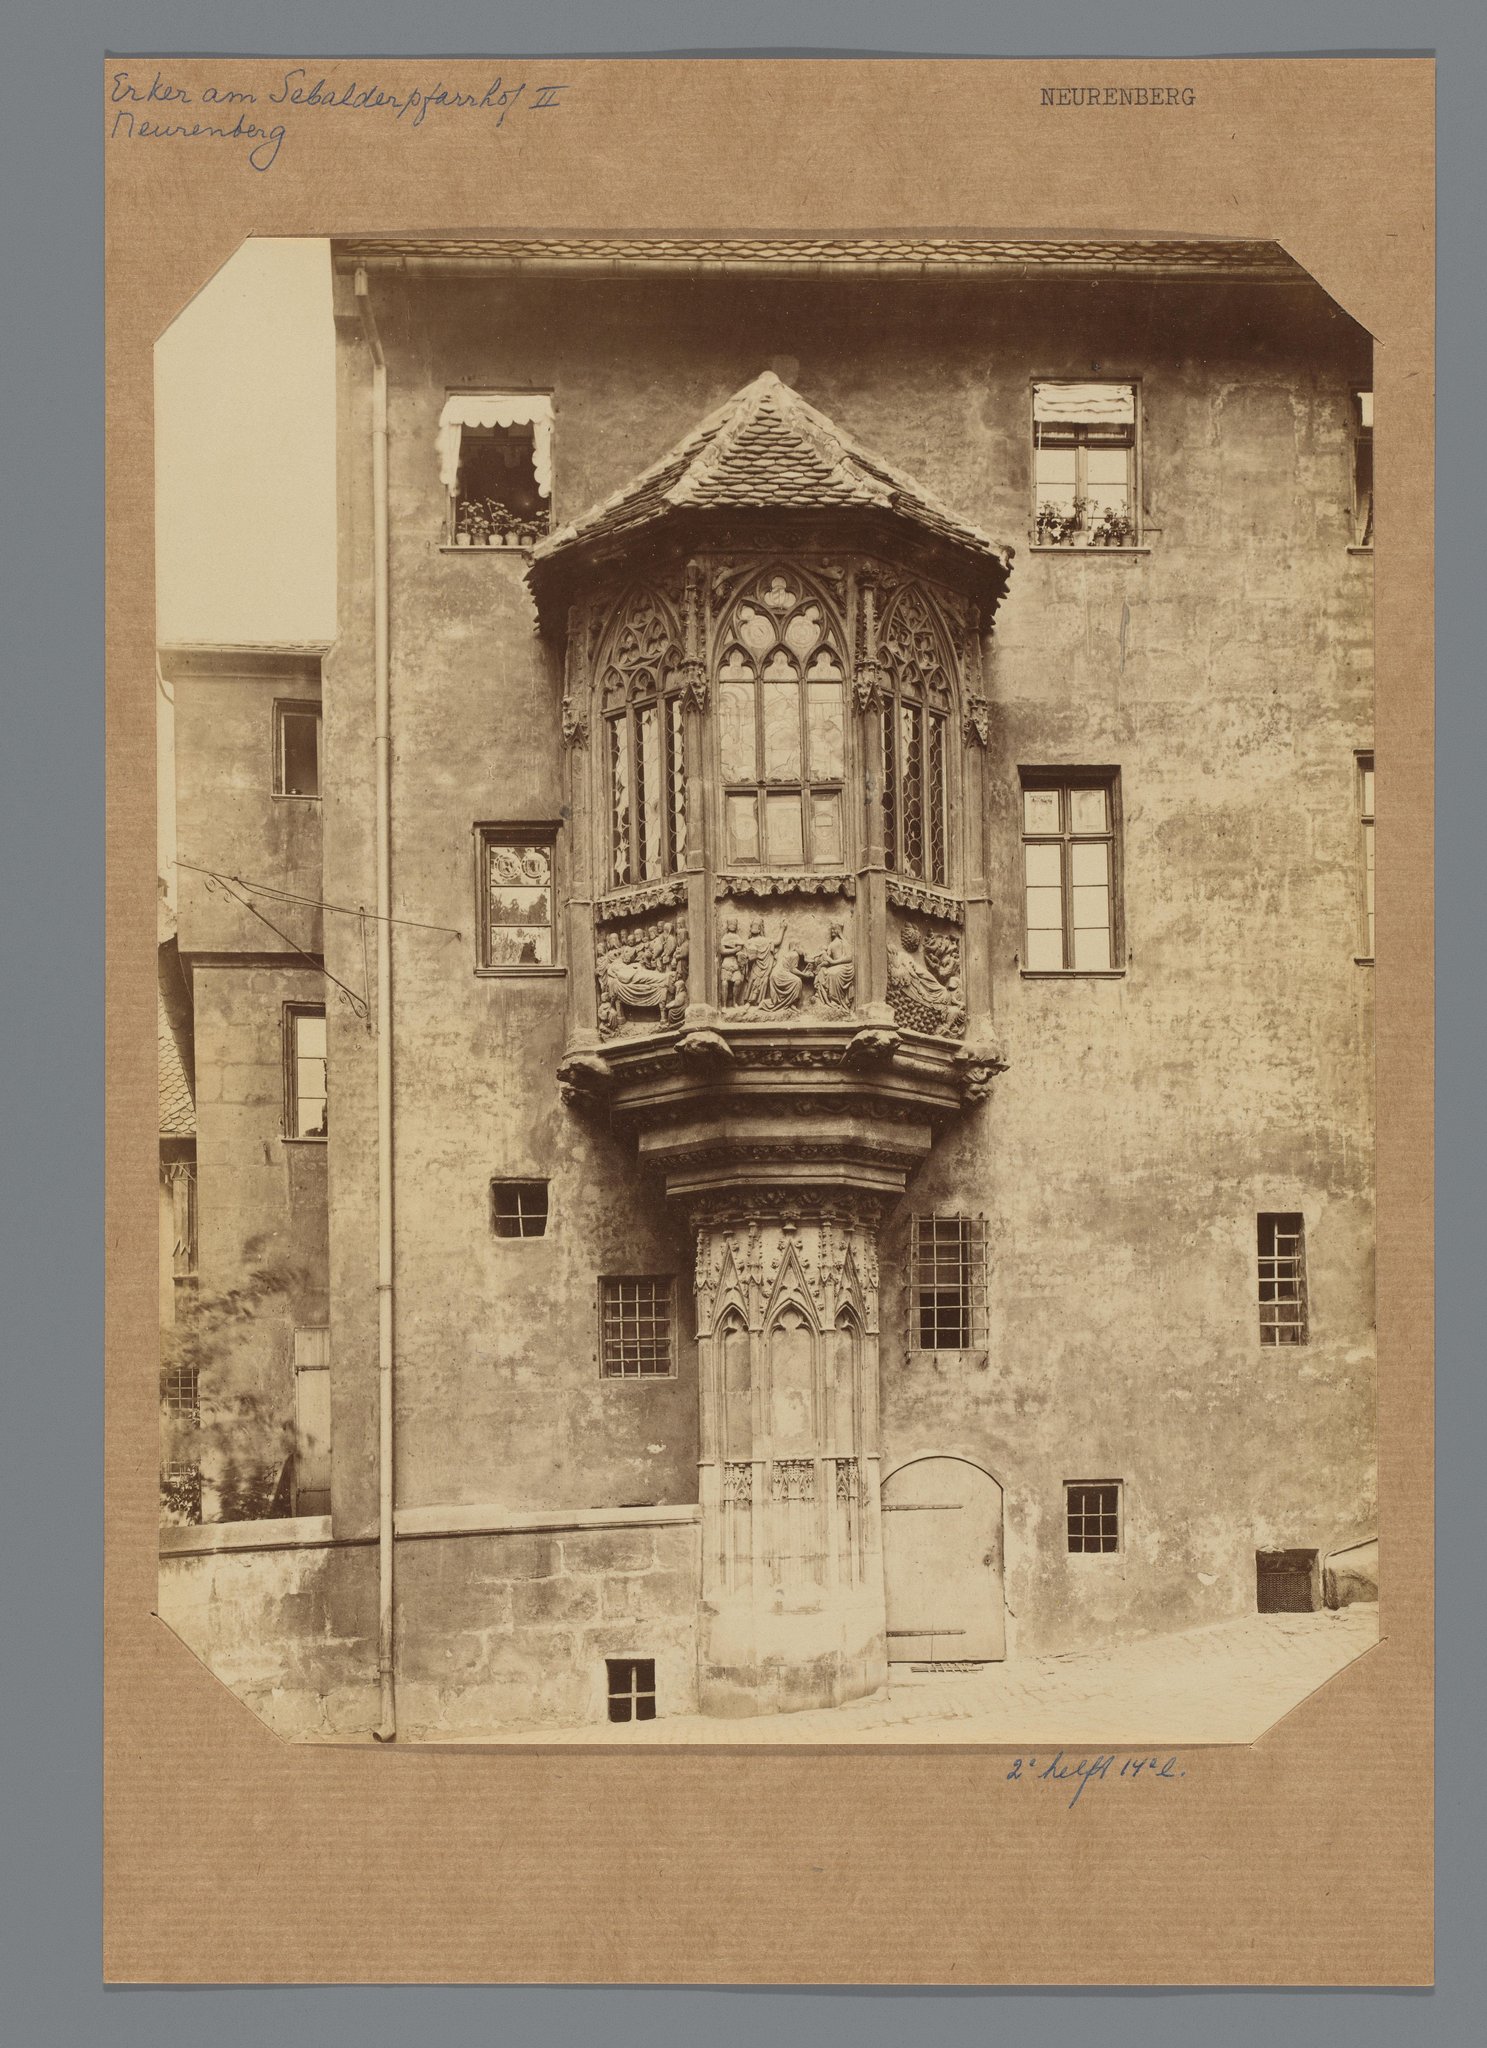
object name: photograph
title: Neurenberg, Erker am Sebalderpfarrhof II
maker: Anonymous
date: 1850-1890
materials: photographic support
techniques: albumen print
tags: neurenberg